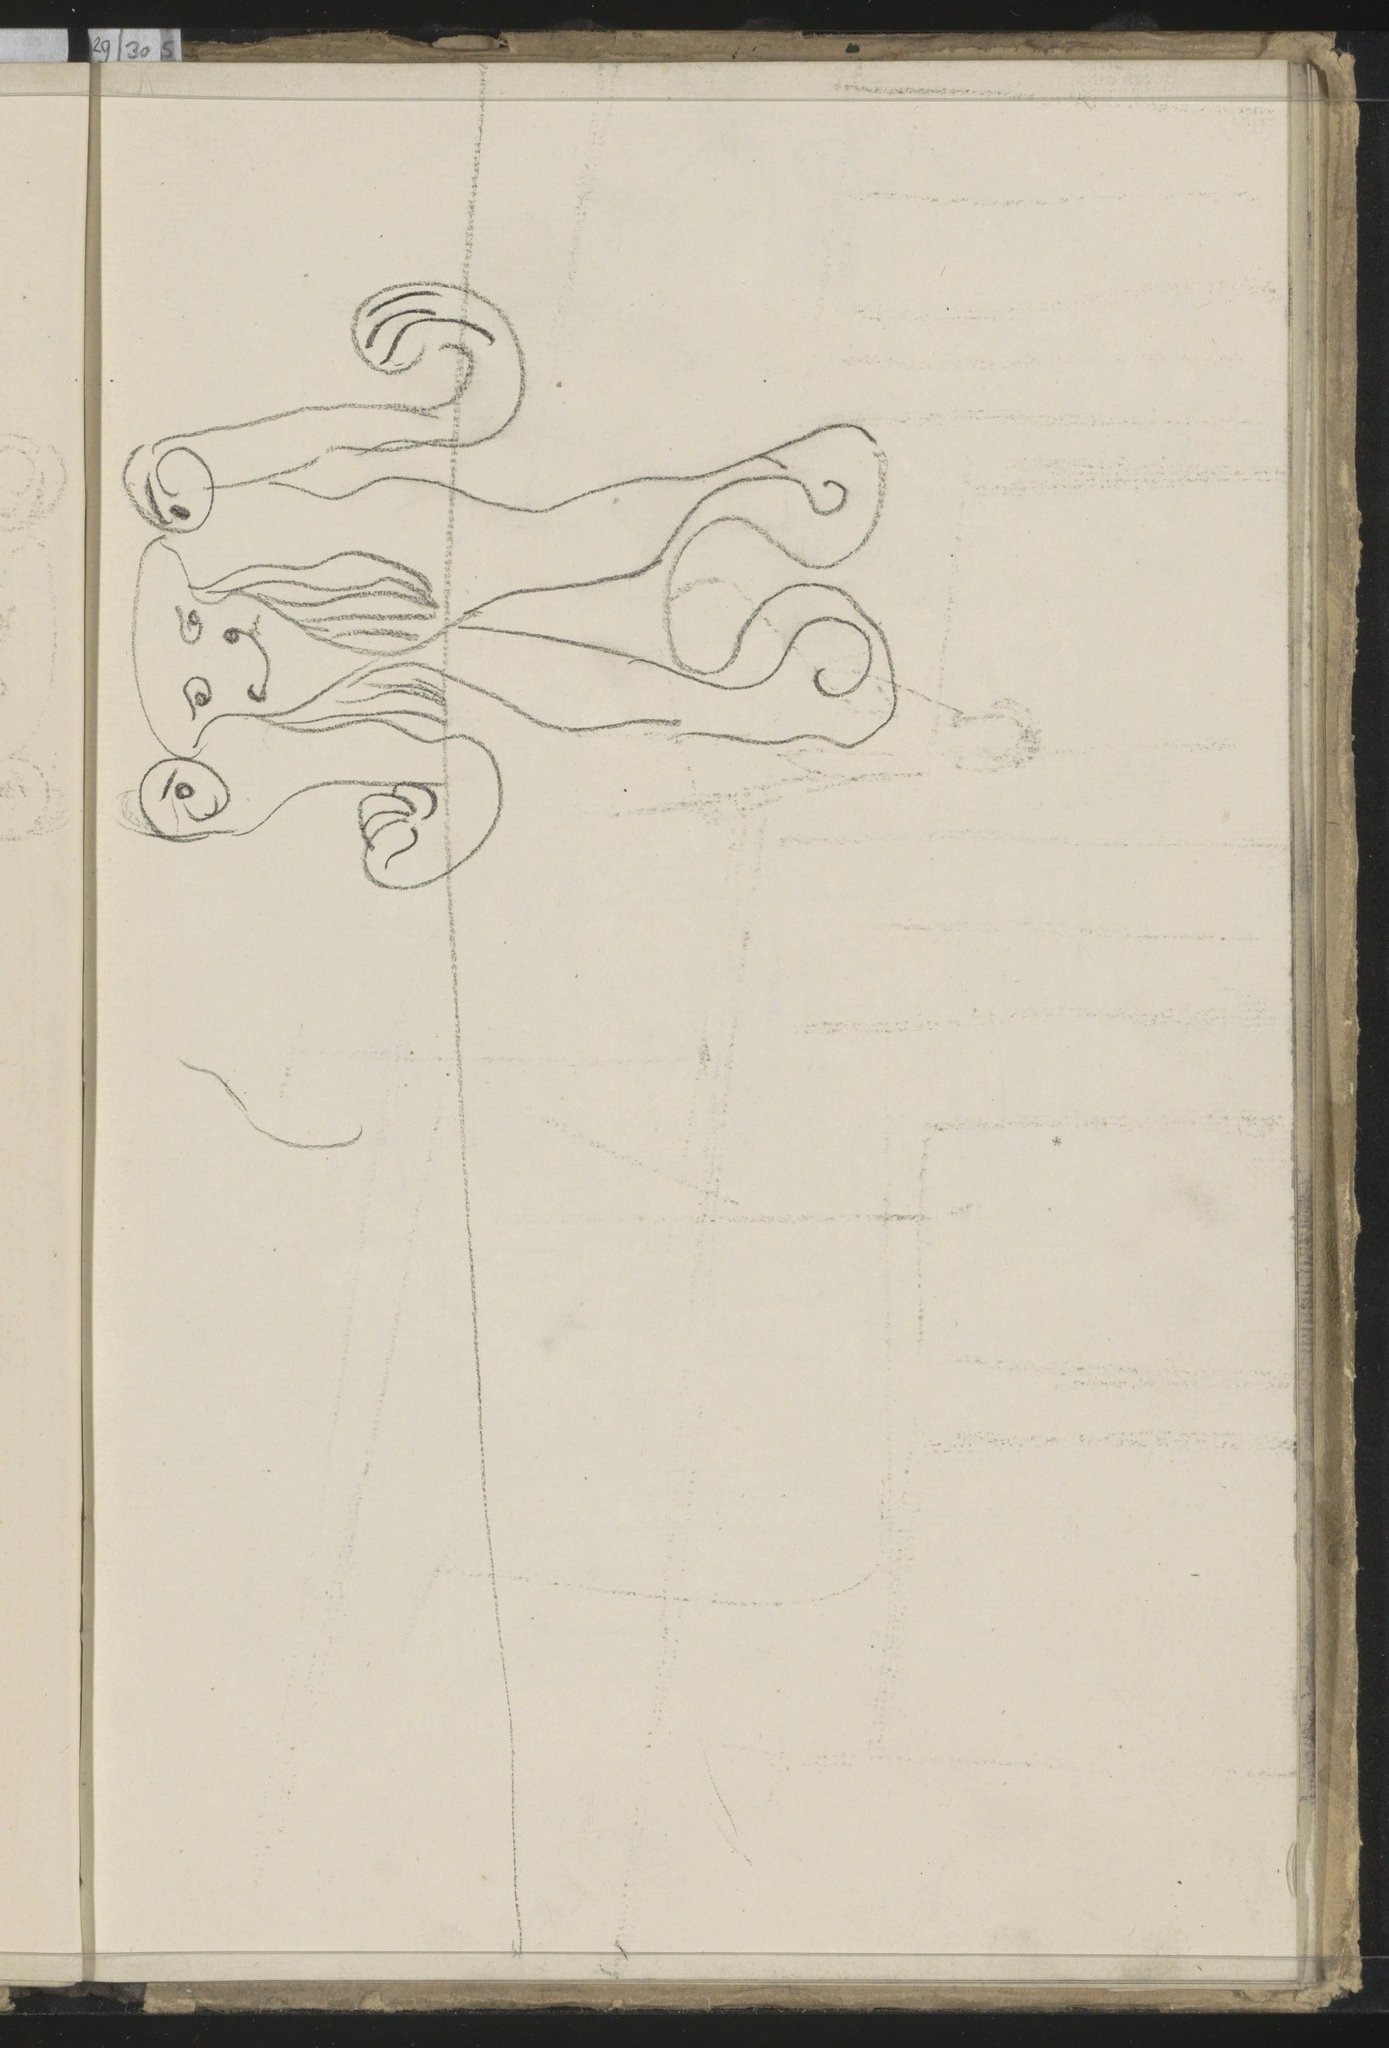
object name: sketchbook leaf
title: Fantasiefiguur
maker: carel adolph lion cachet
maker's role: draughtsman, print maker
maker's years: 1864-1945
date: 1890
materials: chalk, paper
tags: surrealia, surrealistic representations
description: Blad 26 recto uit een schetsboek met 38 bladen.